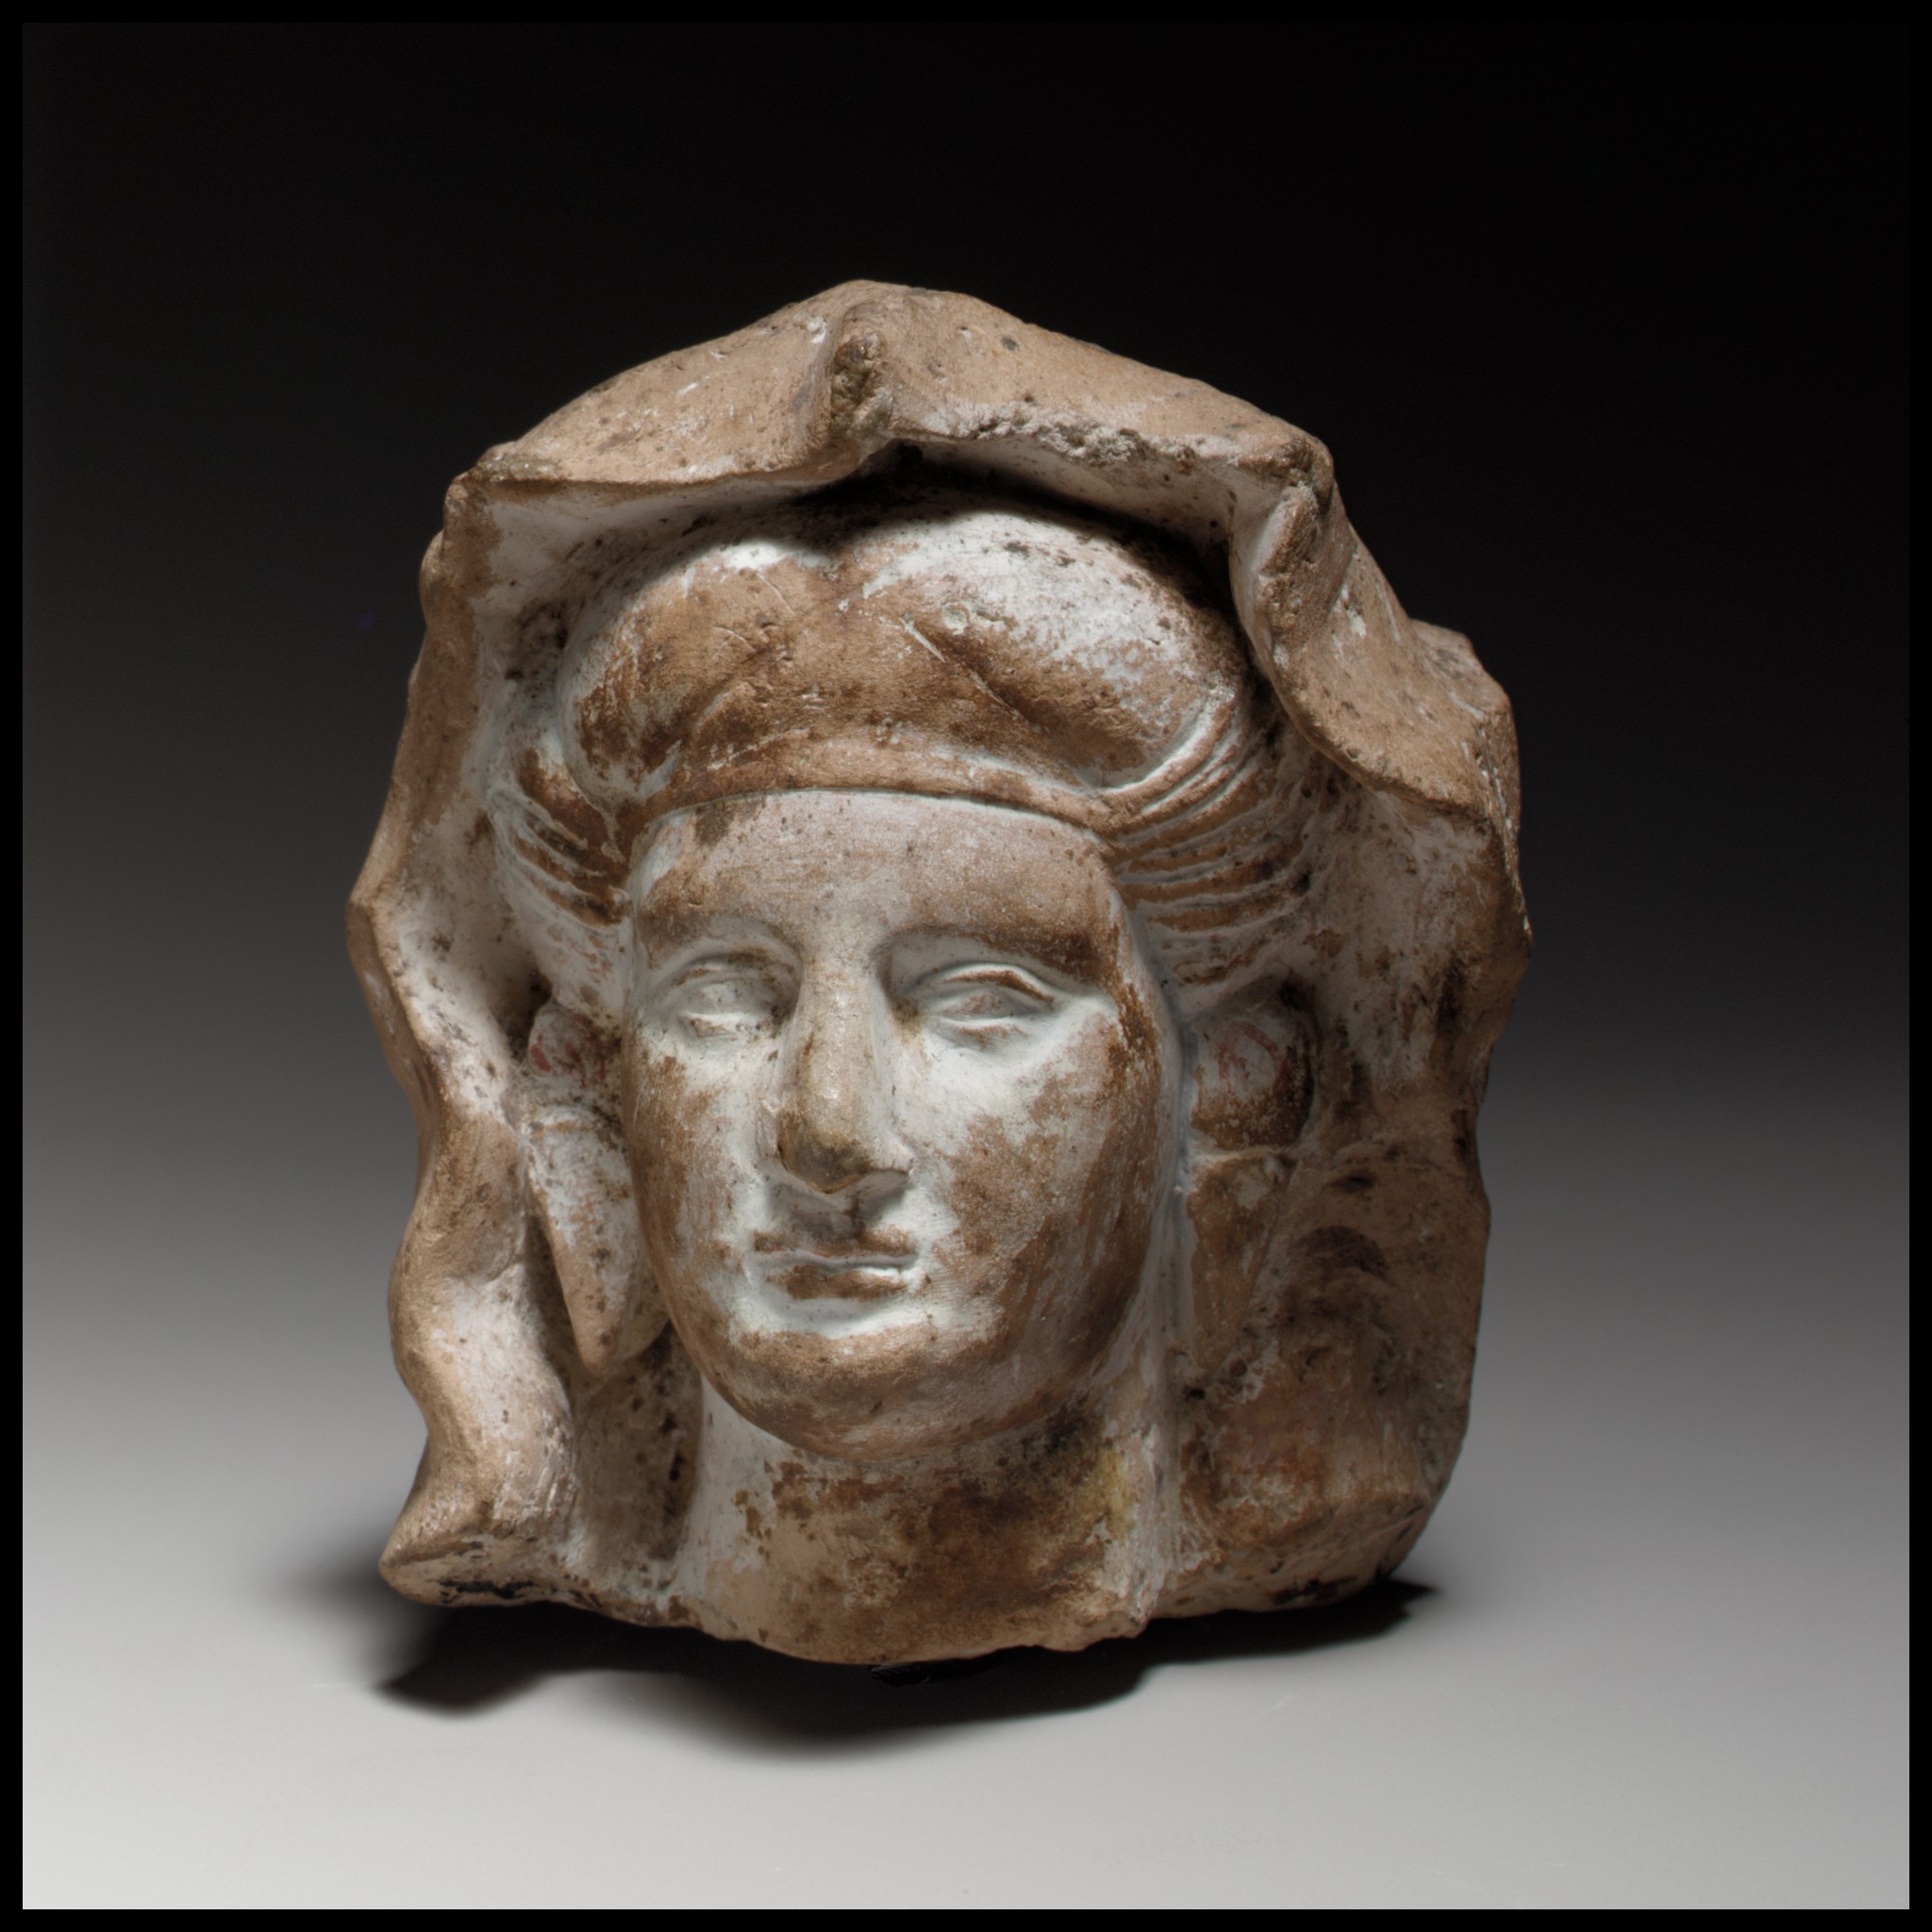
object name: head of a goddess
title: Female head, probably of a goddess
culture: cypriot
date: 400-301 BCE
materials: terracotta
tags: heads,goddess